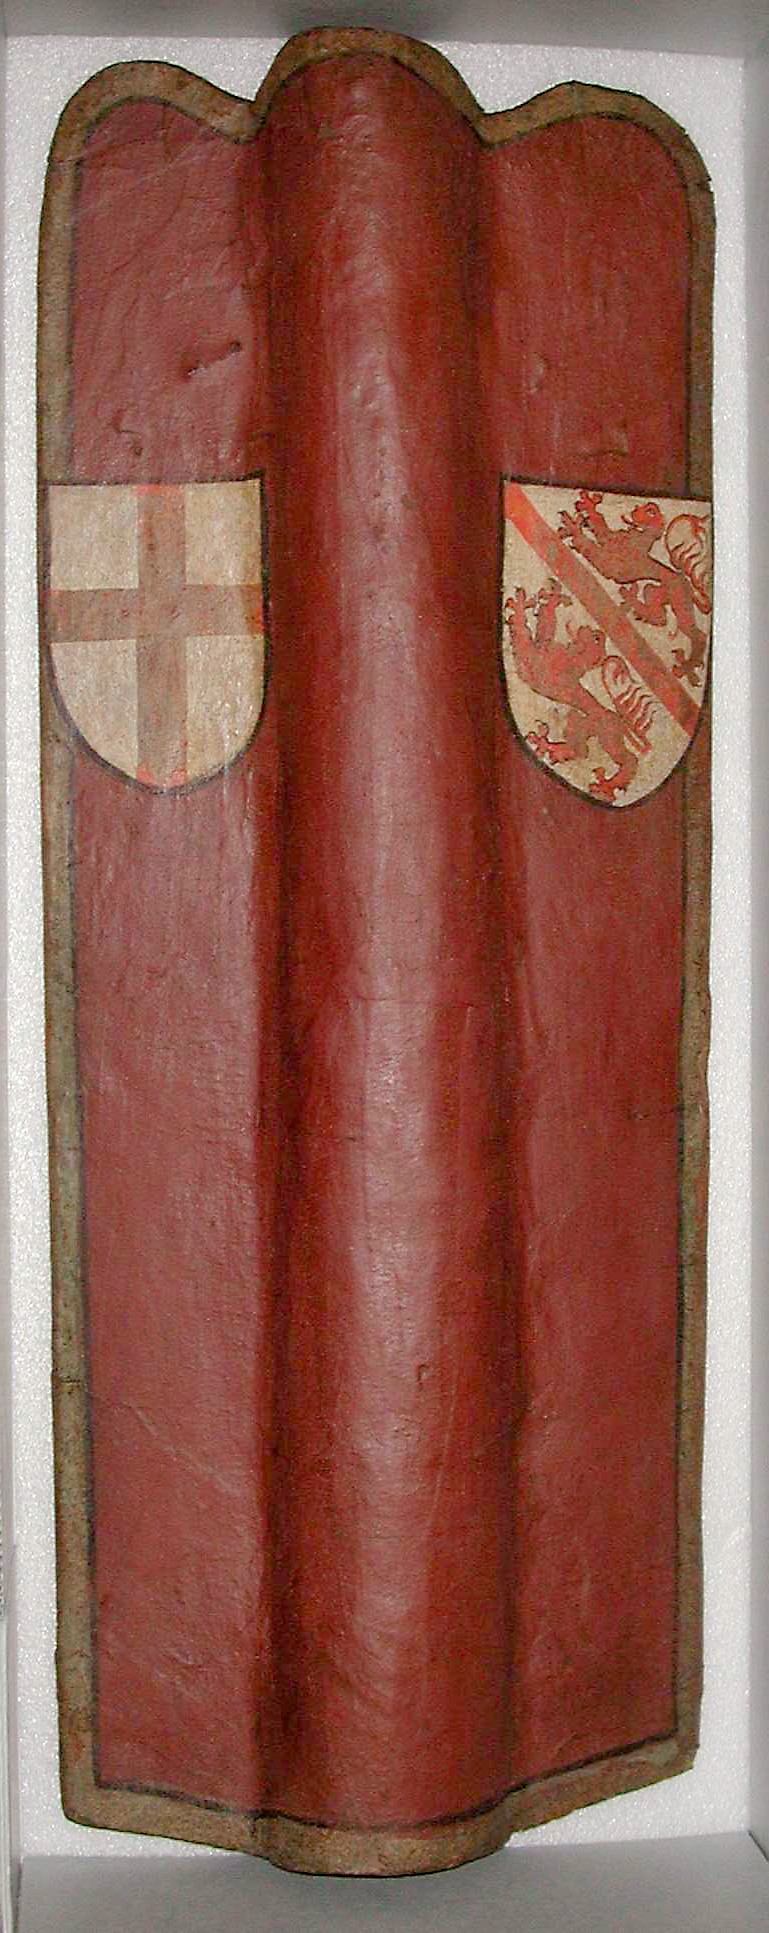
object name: shield pavise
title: Archer's Shield (Pavise)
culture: swiss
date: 1401-1500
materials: gesso, linen, pigment, leather, wood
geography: switzerland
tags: coat of arms